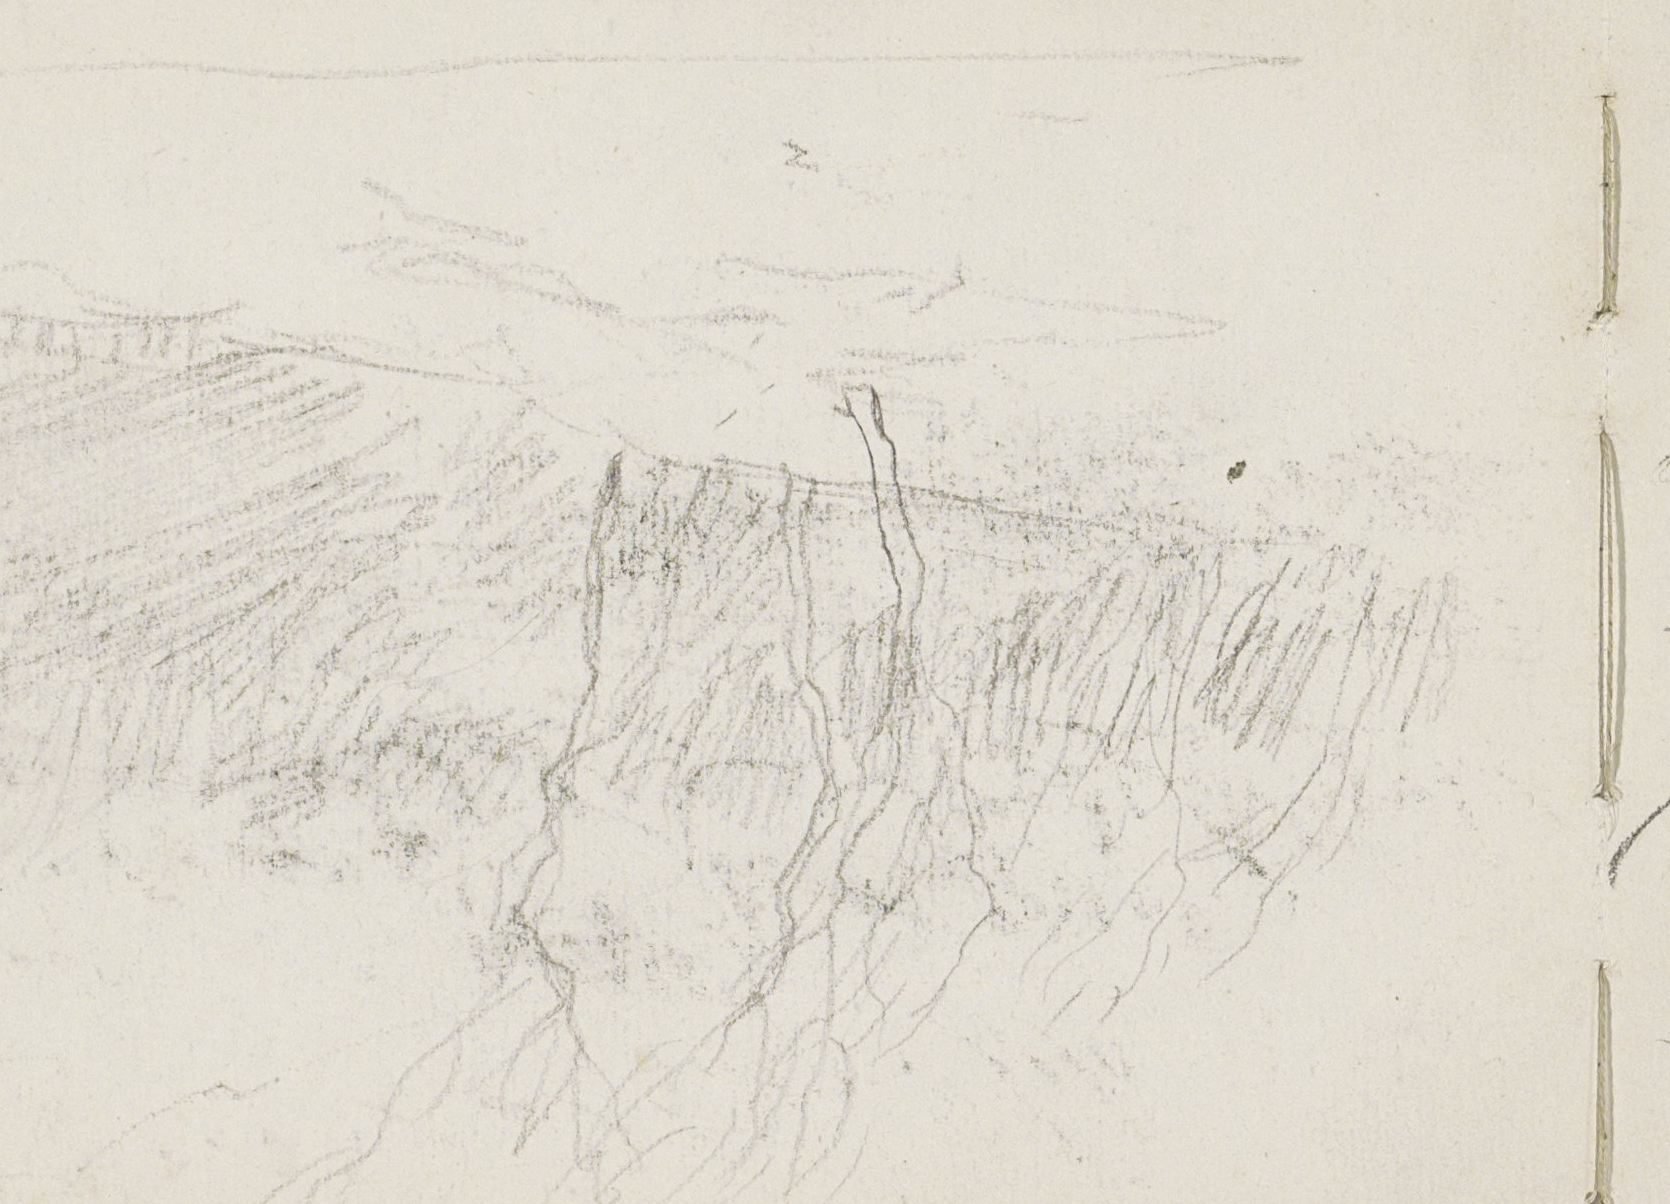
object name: sketchbook leaf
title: Landschap met bomen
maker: anton mauve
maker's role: draughtsman, painter, print maker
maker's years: 1838-1888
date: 1848-1888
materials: chalk, paper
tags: landscapes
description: Blad 11 verso uit een schetsboek met 31 bladen.